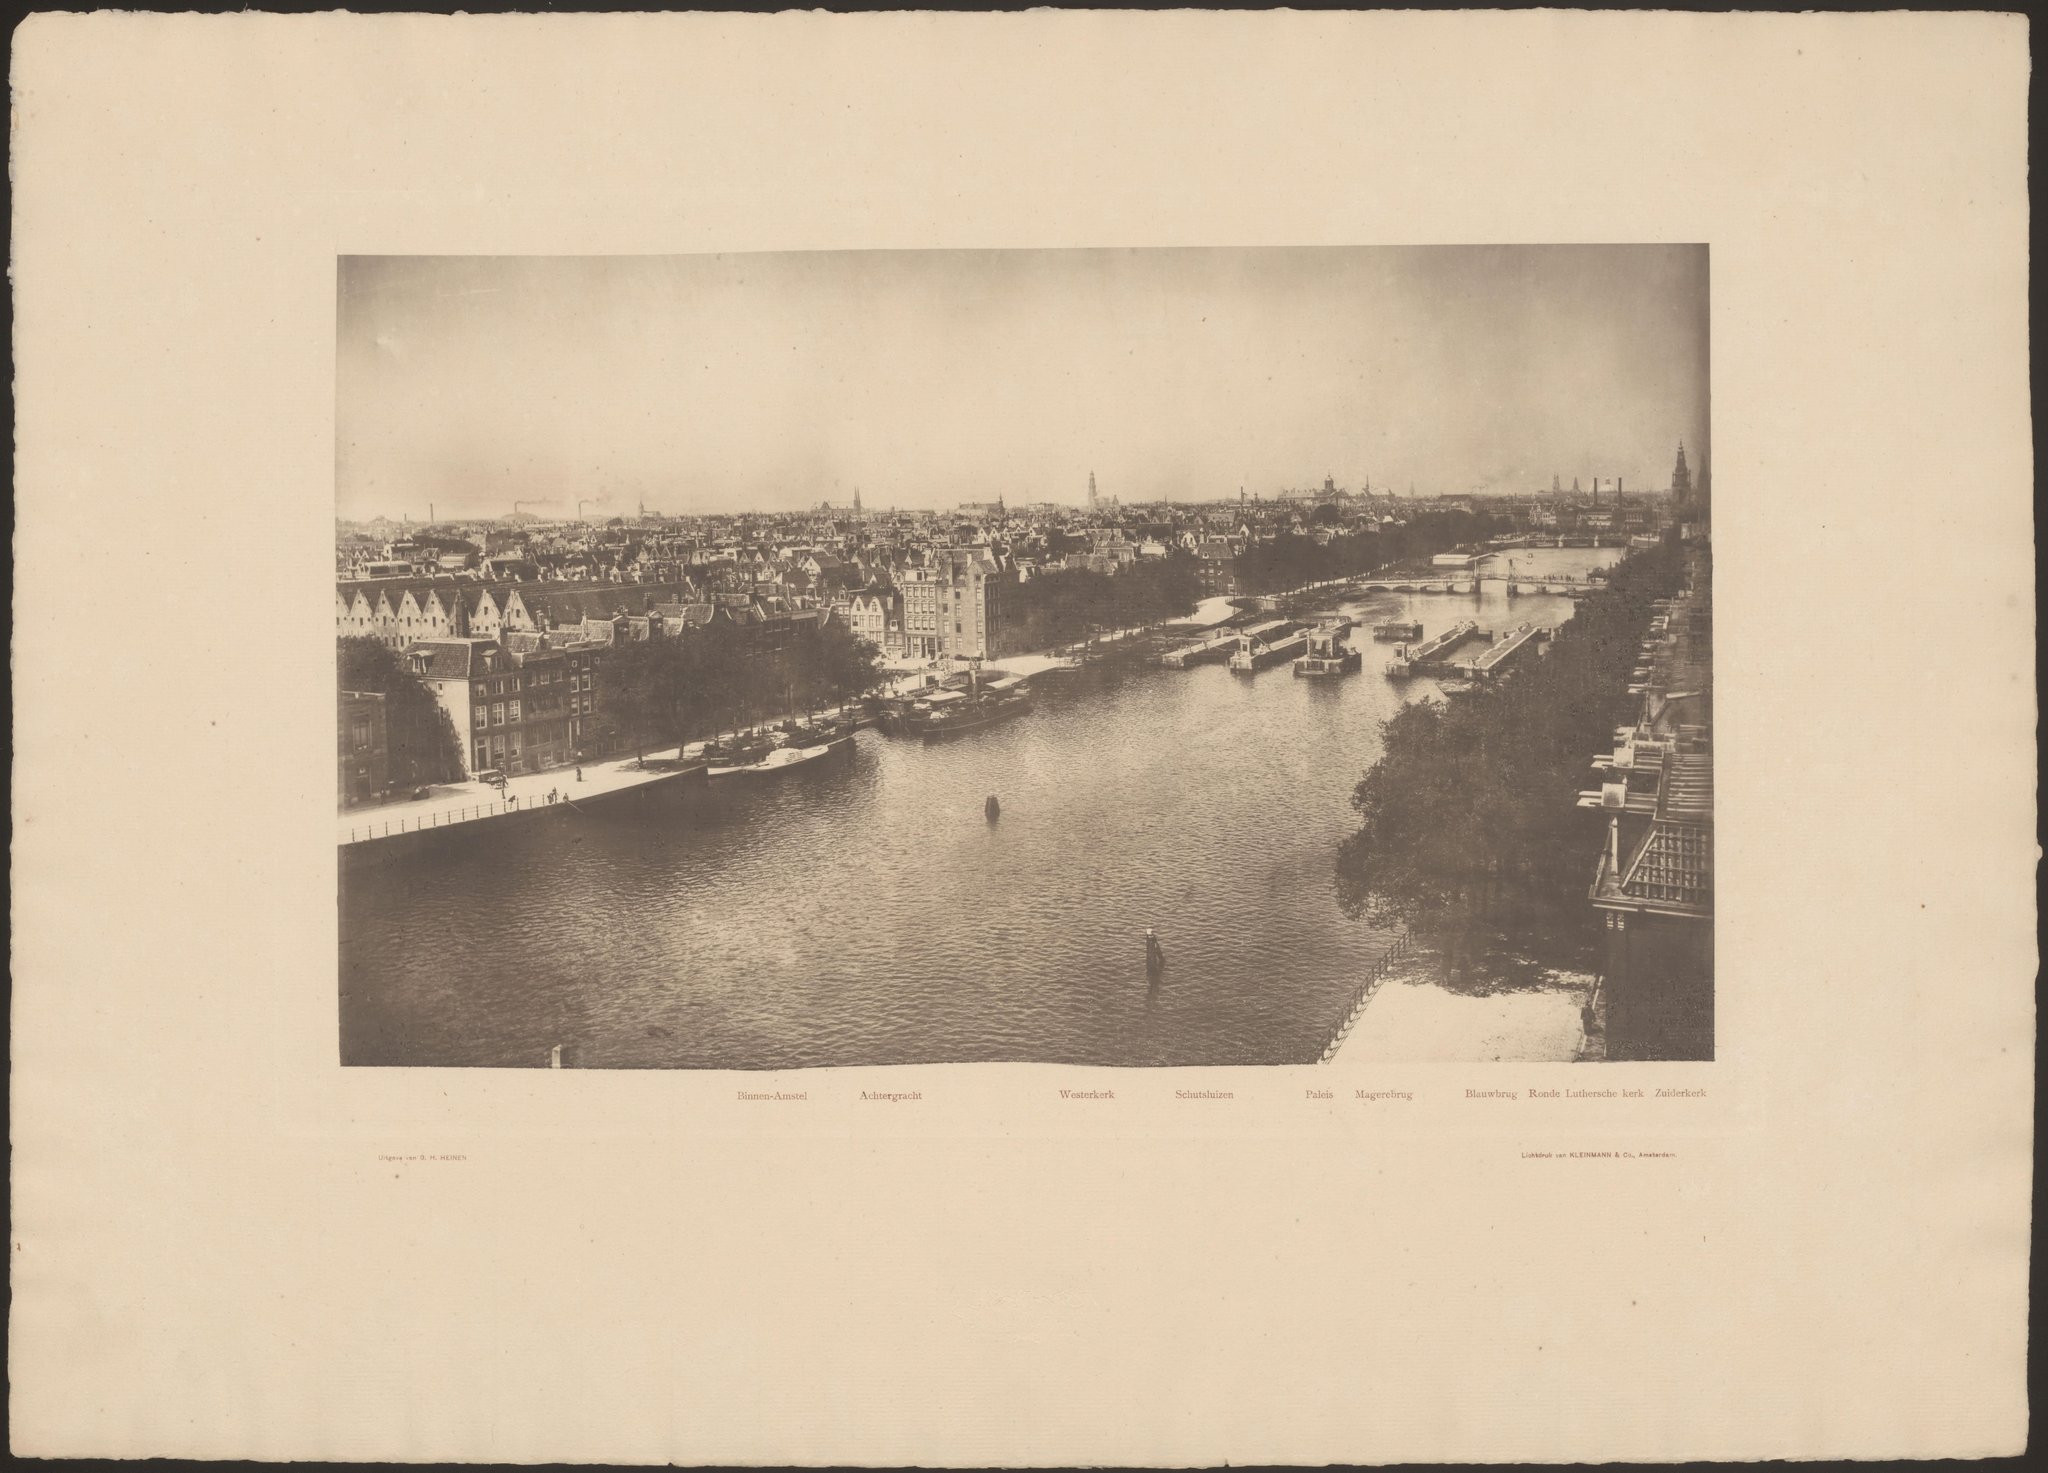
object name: photomechanical print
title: Gezicht op Amsterdam vanaf de Hogesluis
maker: gerrit hendricus heinen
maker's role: painter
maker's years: 1851-1930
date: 1892-1930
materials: paper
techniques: photograph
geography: amsterdam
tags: prospect of city, town panorama, silhouette of city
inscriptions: check stamp: ‘G.H. Heinen Amsterdam / Schilder & Fotograaf’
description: Onderwerpsrubriek binnen de Atlas Amsterdam: Panorama's en verzamelprenten.